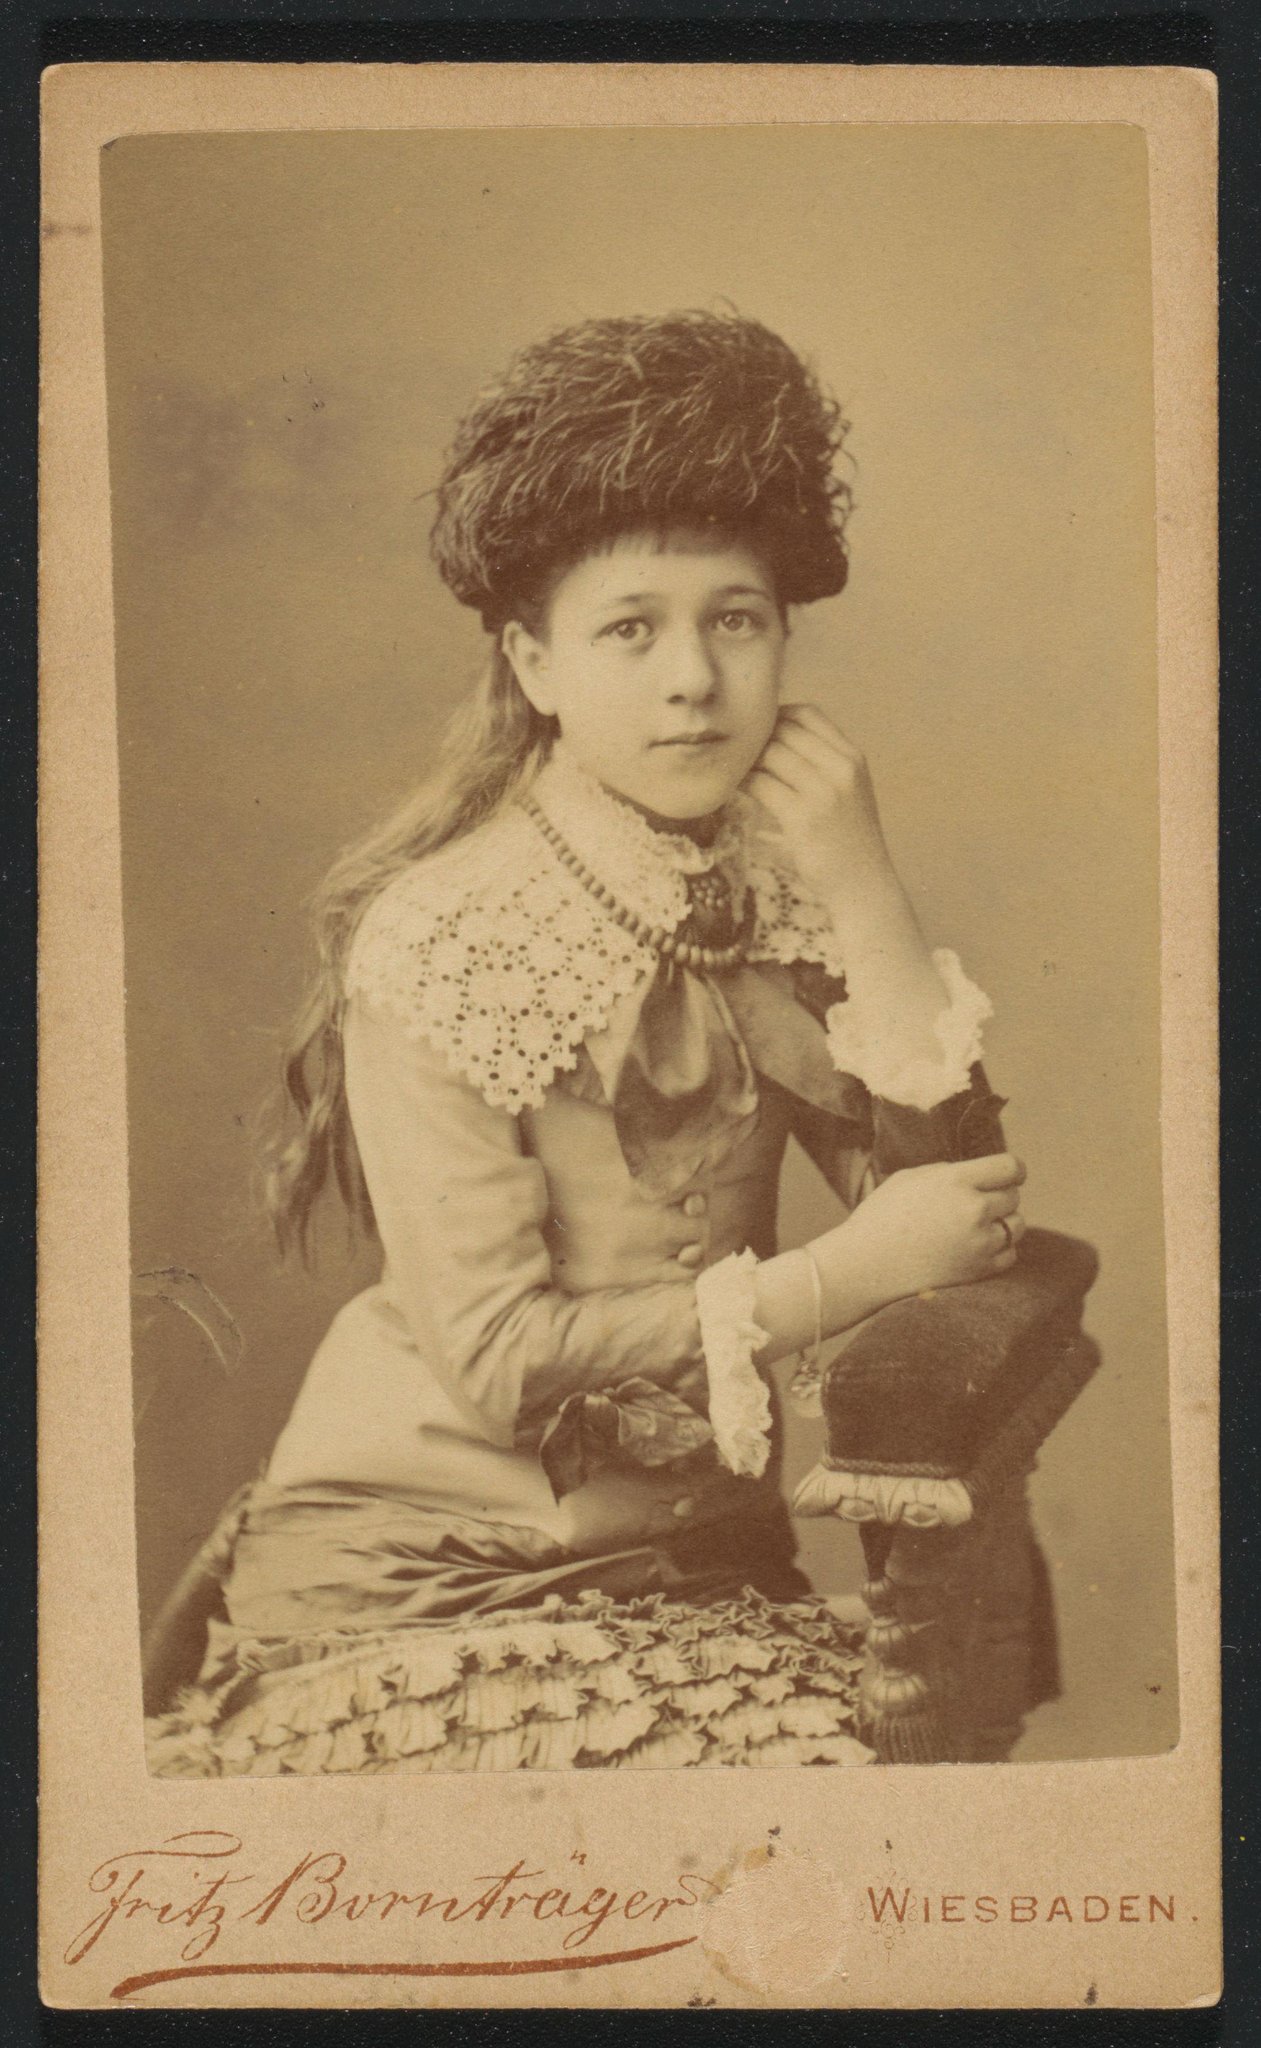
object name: photograph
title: Portret van [(...)] Elisabeth Bosch Reitz als jong meisje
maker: fritz bornträger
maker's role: fotograaf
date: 1883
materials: cardboard, photographic support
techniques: albumen print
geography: wiesbaden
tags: adolescent, young woman, maiden, head-gear: hat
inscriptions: address: ‘Wilhelmsallee neben der neuen Colonade vis-à-vis den vier Jahreszeiten’, inscription: ‘[...] Elisabeth Bosch Reitz 1883-20 Januari’